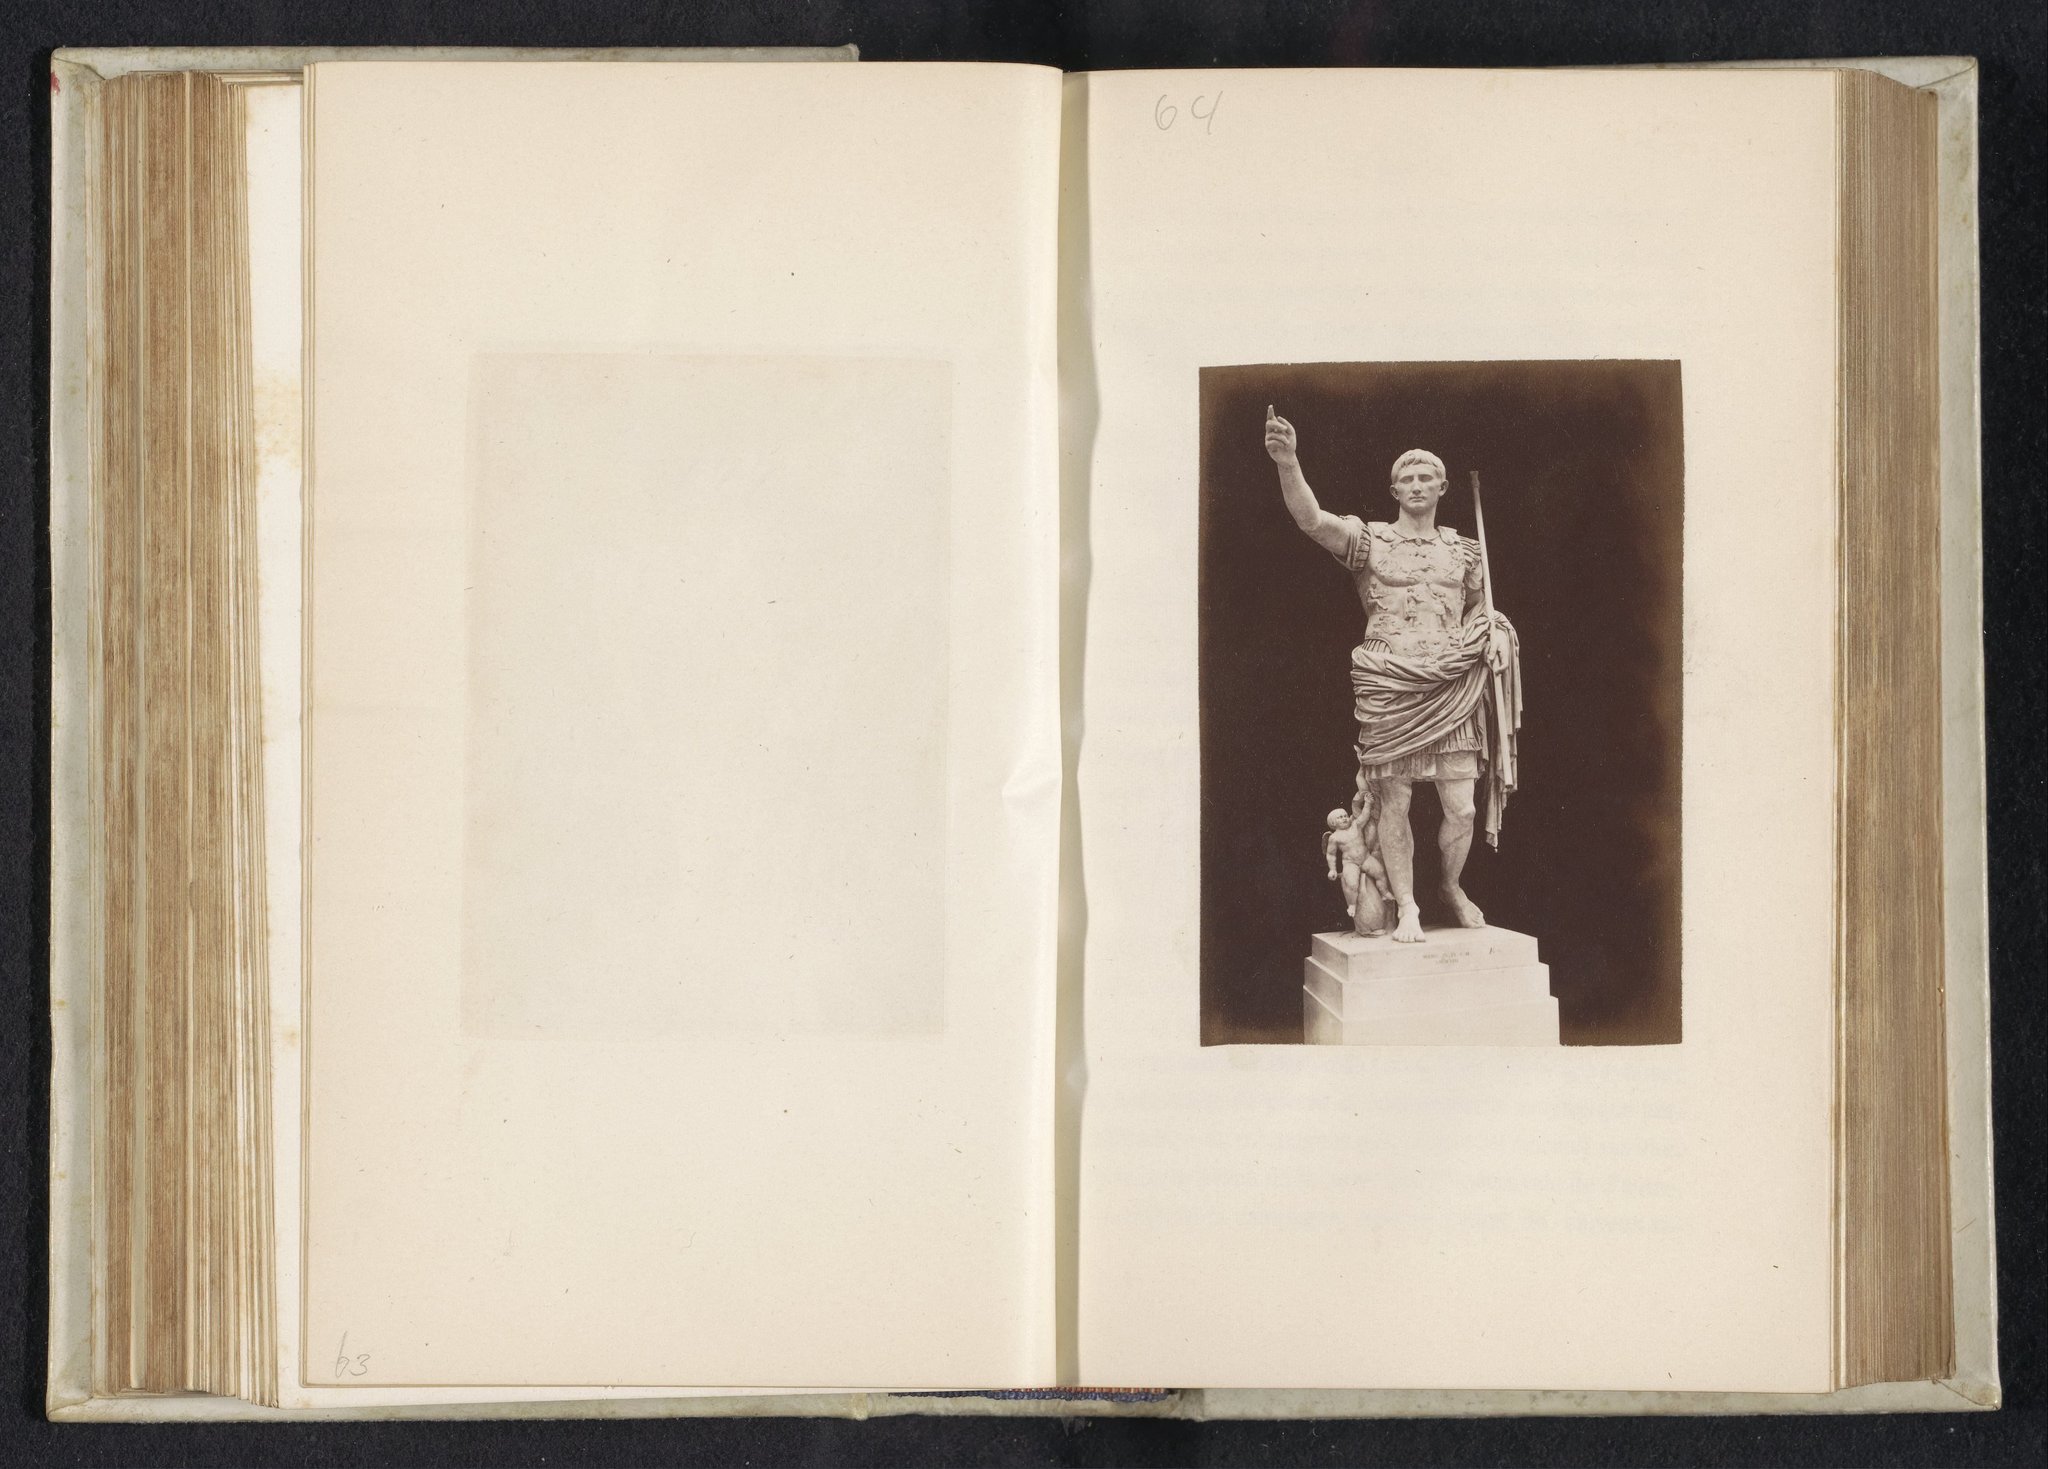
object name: page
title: Augustus van Prima Porta in de Vaticaanse Musea te Vaticaanstad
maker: Anonymous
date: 1850-1860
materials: photographic support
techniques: albumen print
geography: vatican museums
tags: portrait of augustus, sculpture